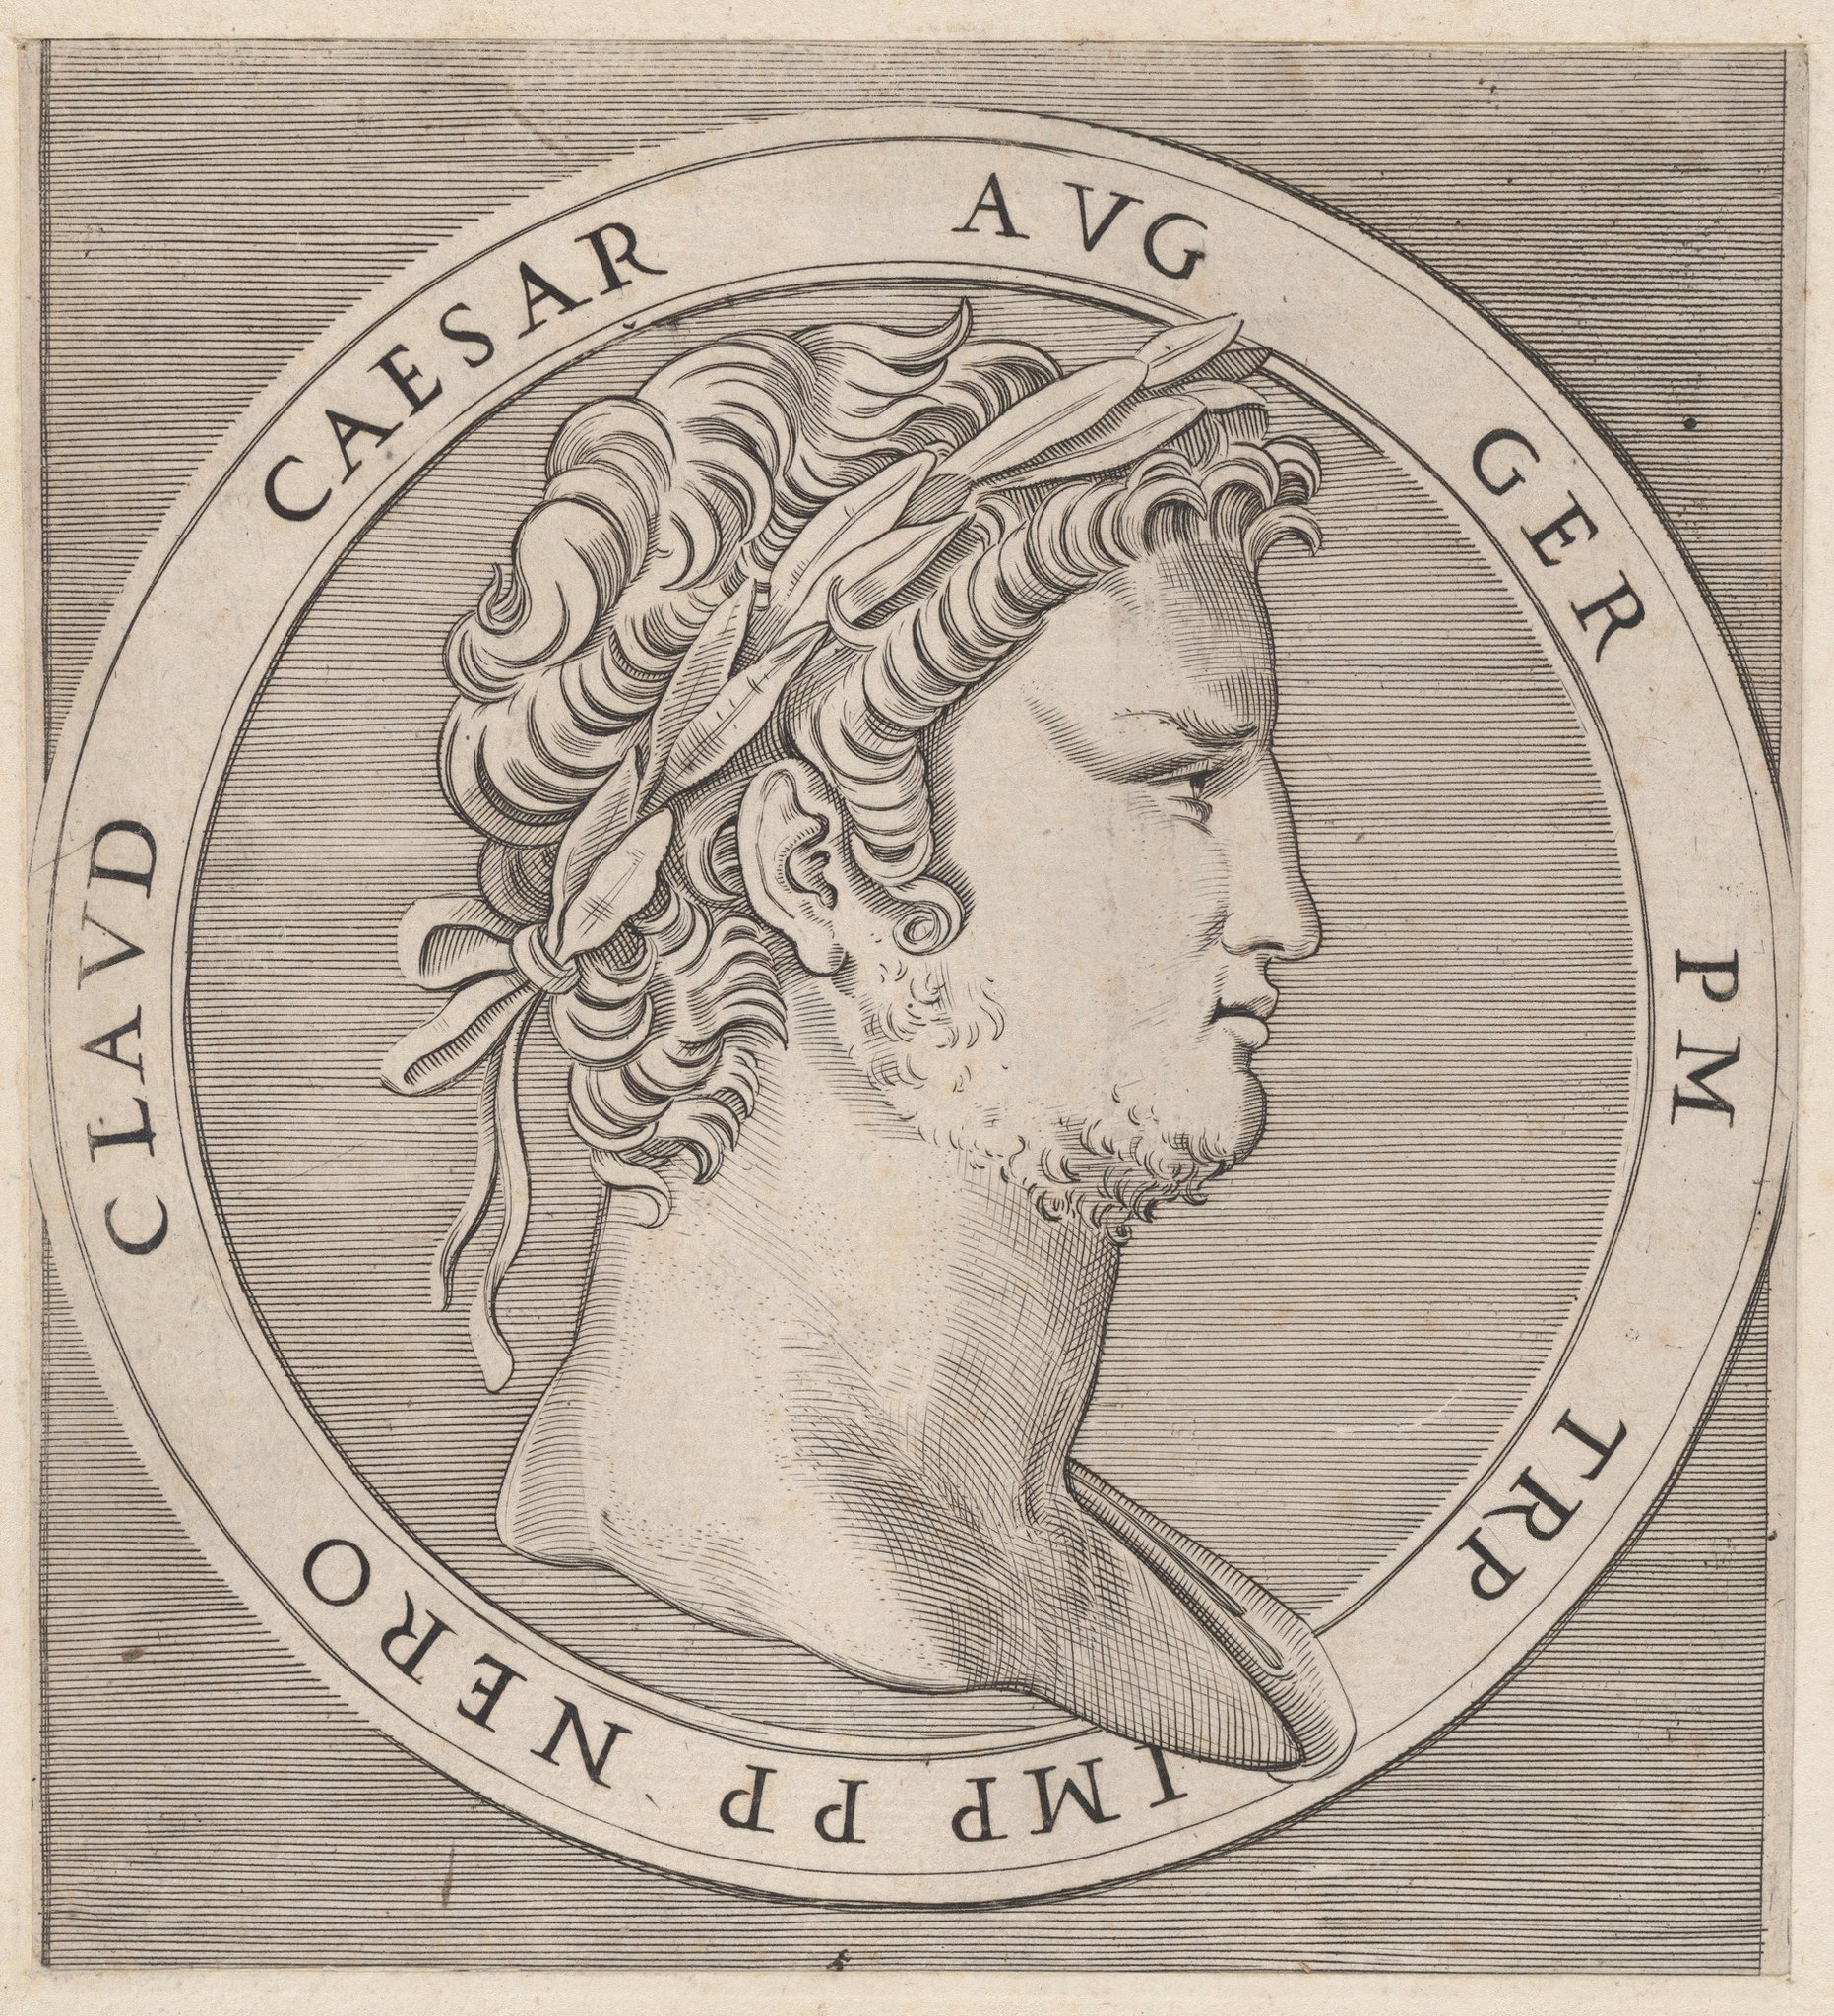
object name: print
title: Nero, from The Twelve Caesars, from "Speculum Romanae Magnificentiae"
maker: marcantonio raimondi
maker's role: artist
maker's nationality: italian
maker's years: 1475-1534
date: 1500-1534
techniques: engraving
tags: men,profiles